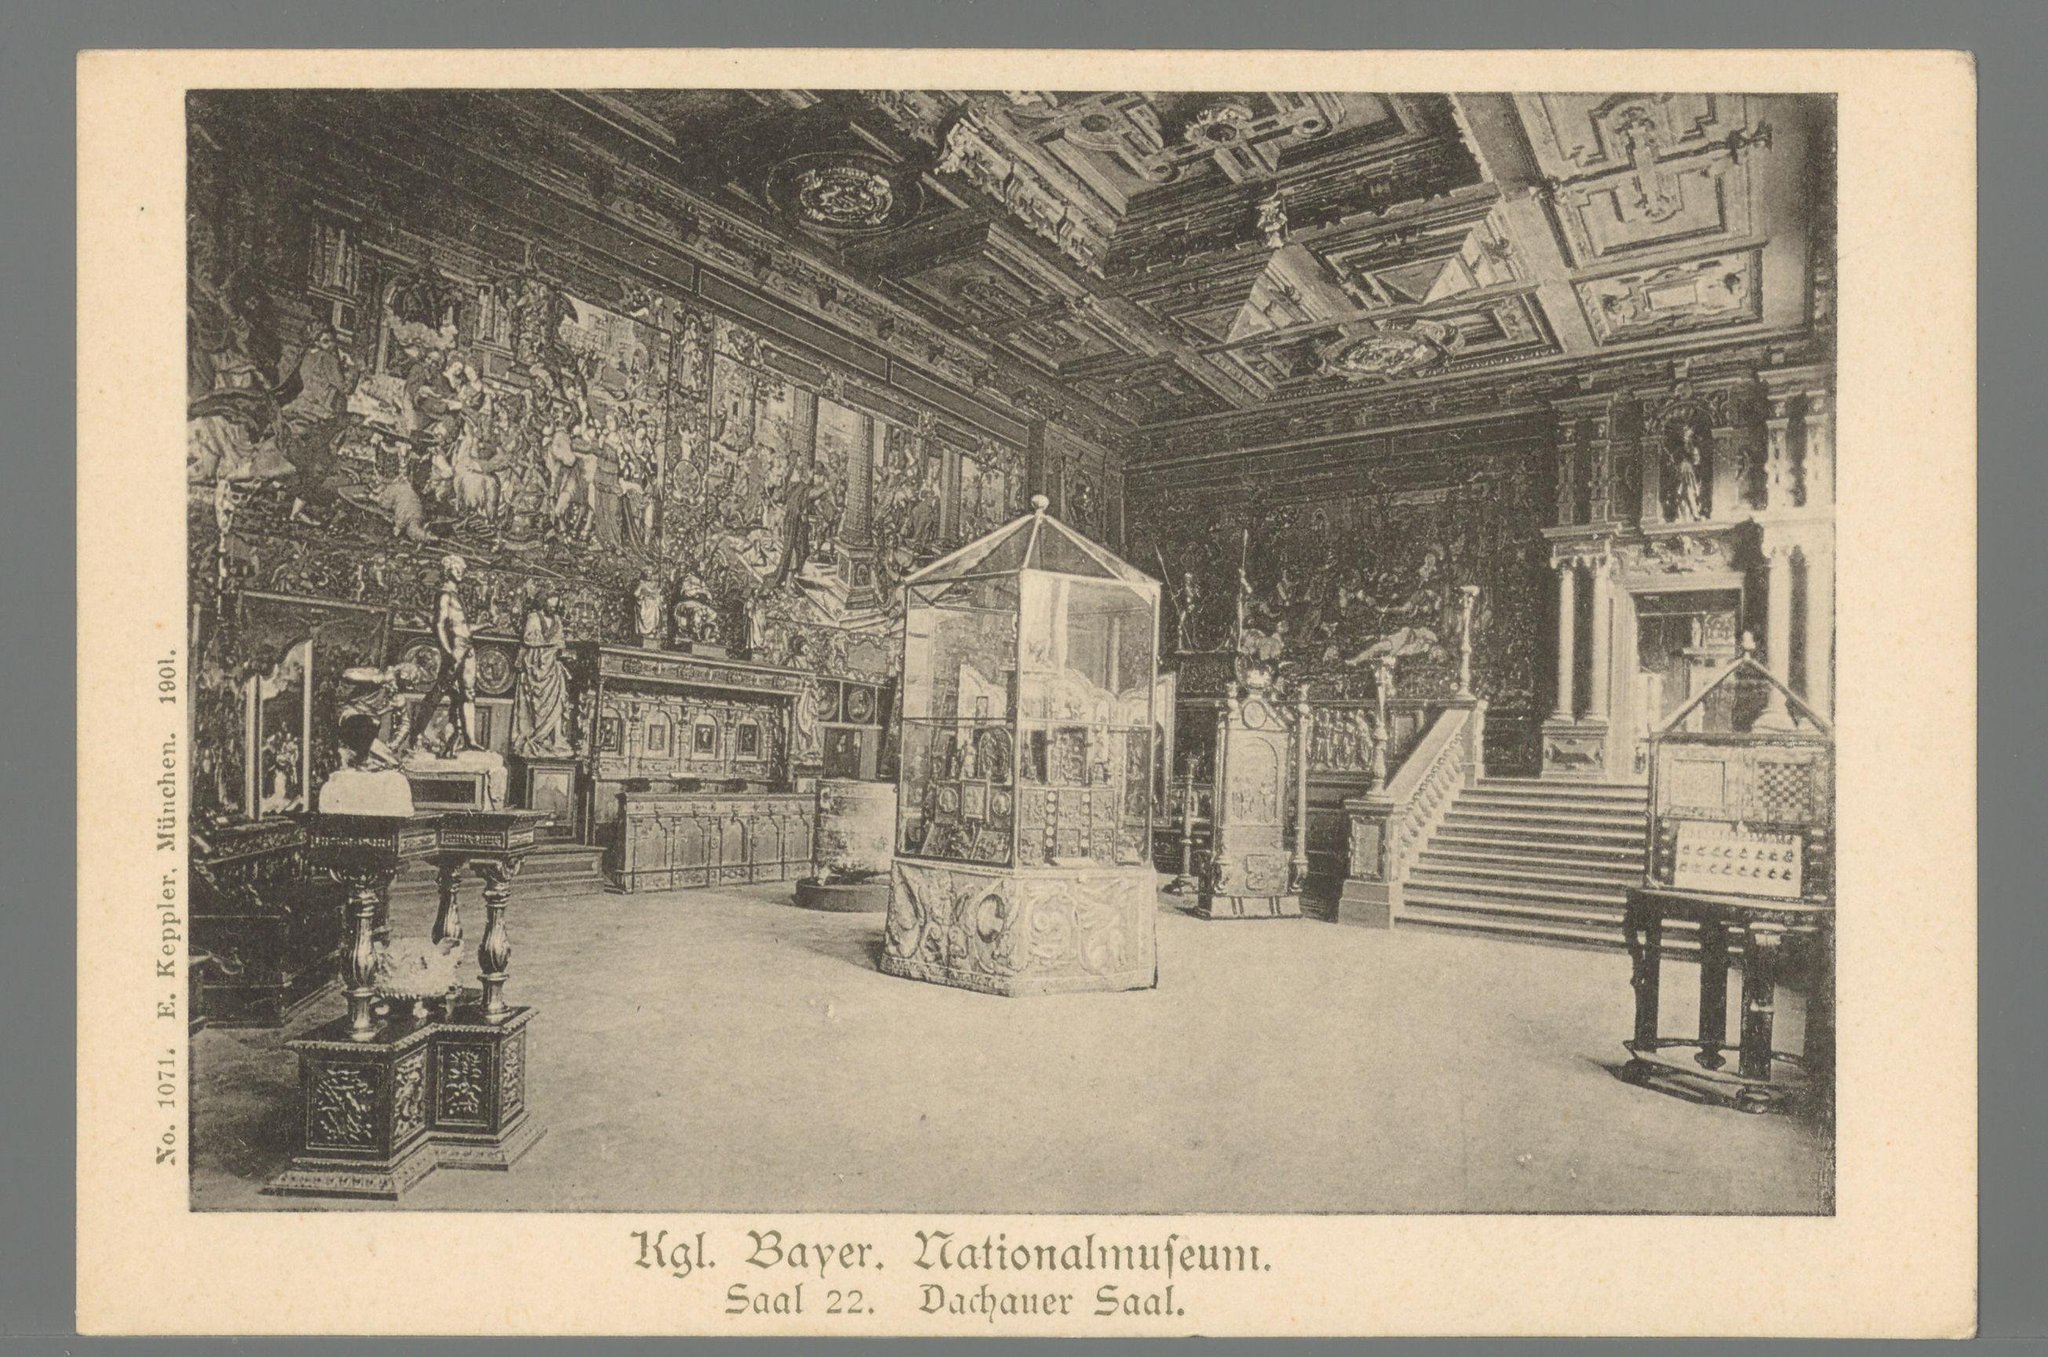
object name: ansichtkaart, prentbriefkaart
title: Kgl. Bayer. Nationalmuseum. Saal 22. Dachauer Saal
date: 1901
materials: cardboard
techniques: photograph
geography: munich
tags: permanent exhibition, museum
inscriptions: date